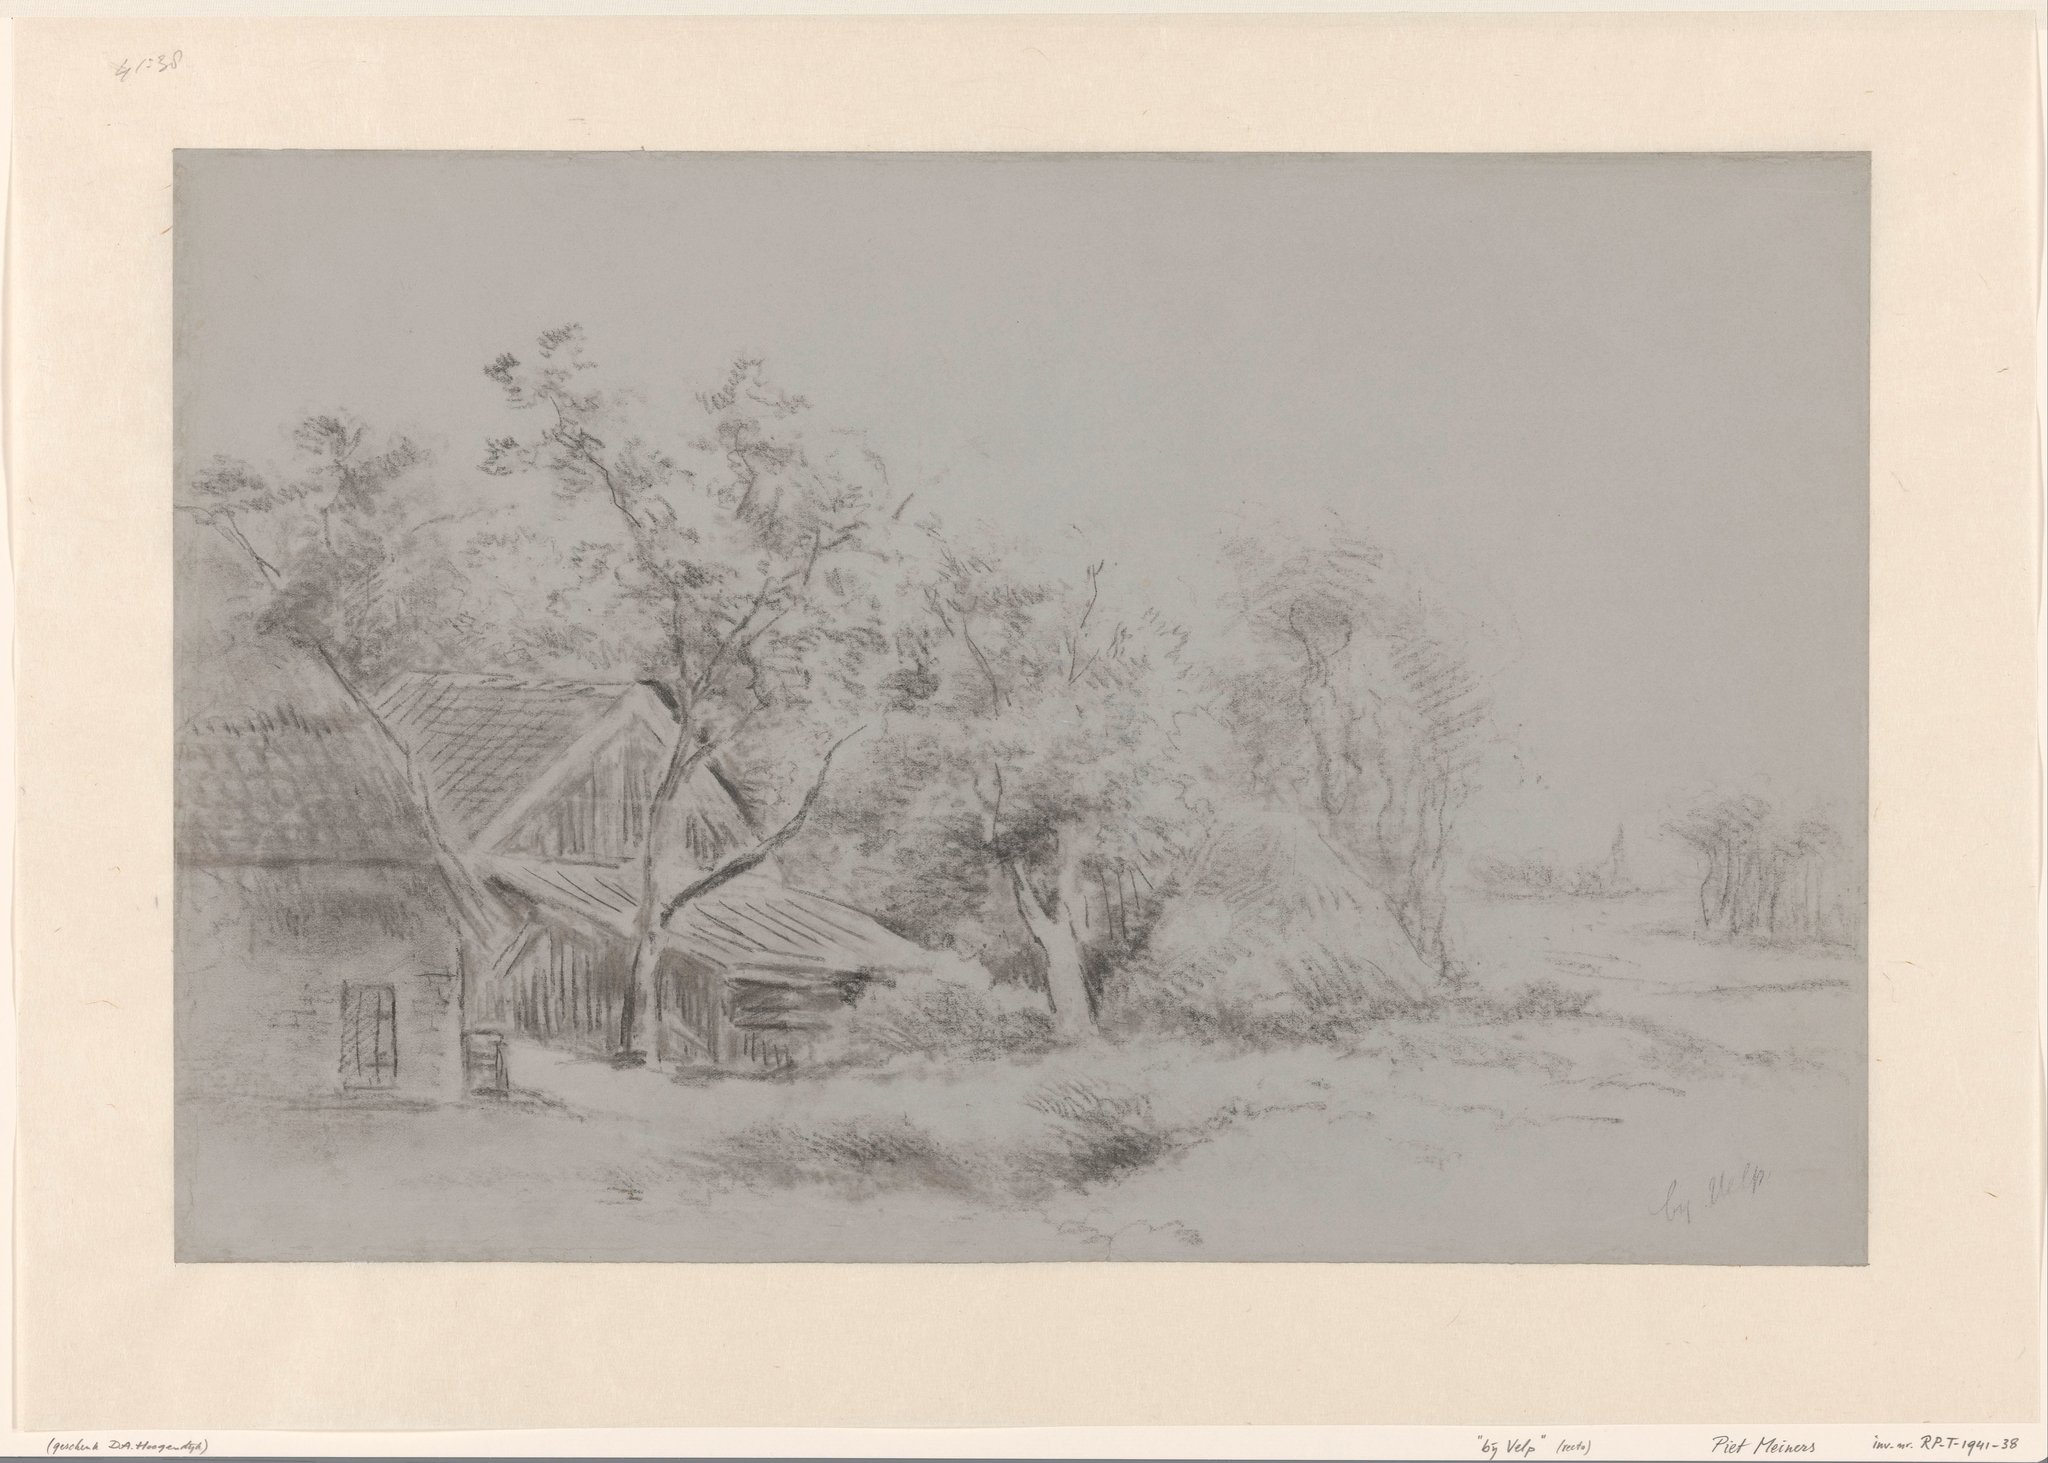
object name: drawing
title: Boerenhuizen onder bomen in de omgeving van Velp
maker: piet meiners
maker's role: draughtsman, painter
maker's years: 1857-1903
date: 1867-1903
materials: chalk, paper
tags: farm (building)